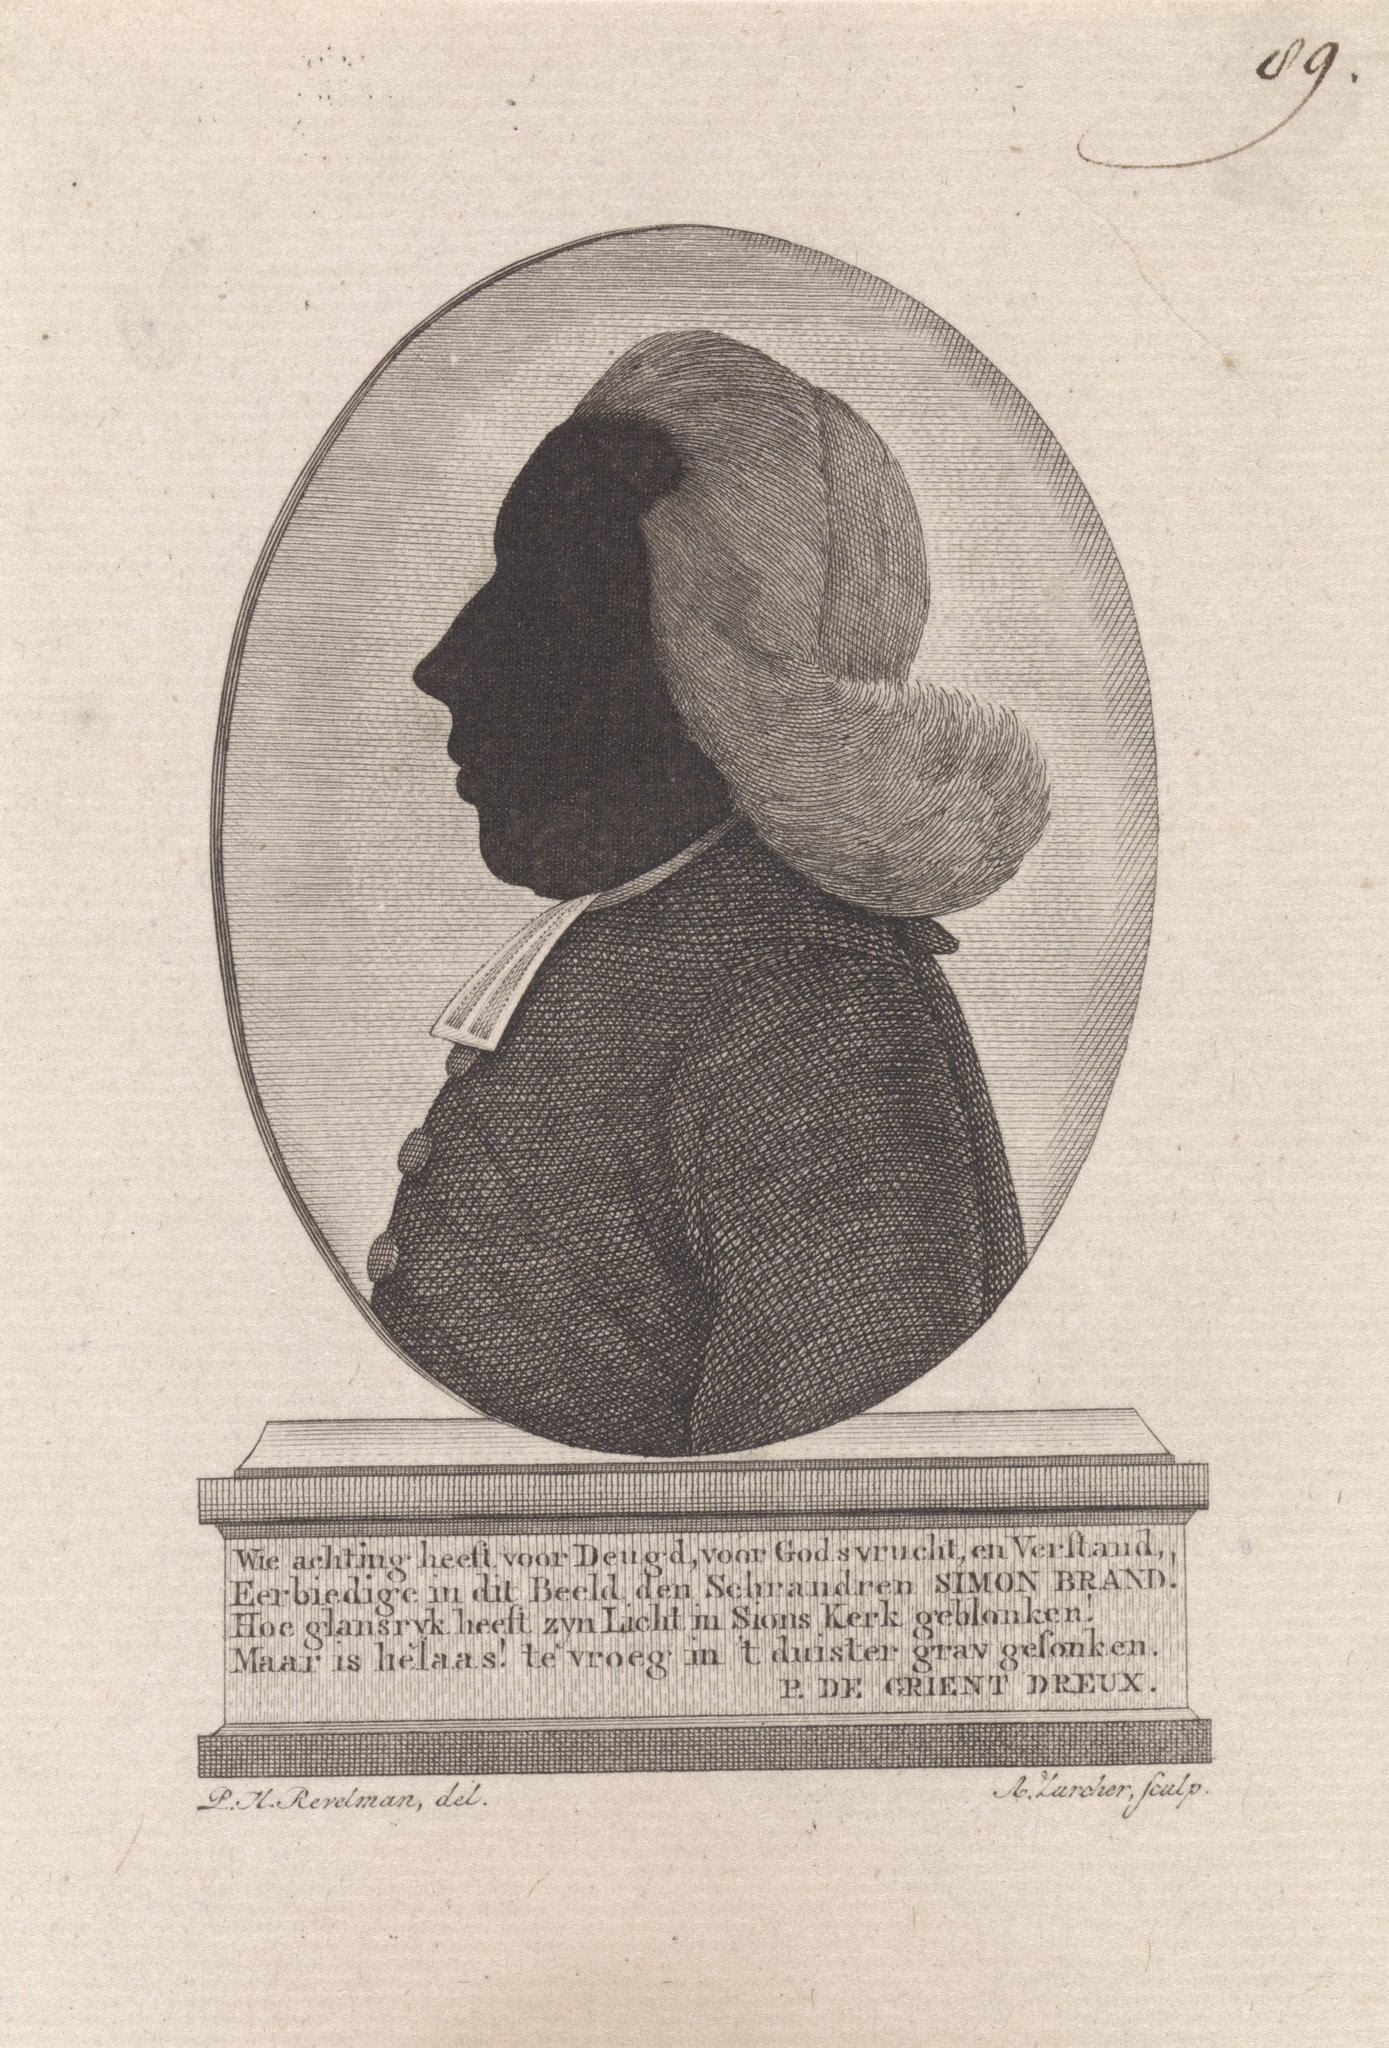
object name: print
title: Silhouetportret van Simon van Someren Brand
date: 1800-1802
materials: paper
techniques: engraving, etching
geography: amsterdam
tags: dordrecht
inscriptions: collector's mark: Lugt 2228, number: ‘89.’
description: Silhouetportret van predikant Simon van Someren Brand. Onder het portret een vierregelig vers in het Nederlands.